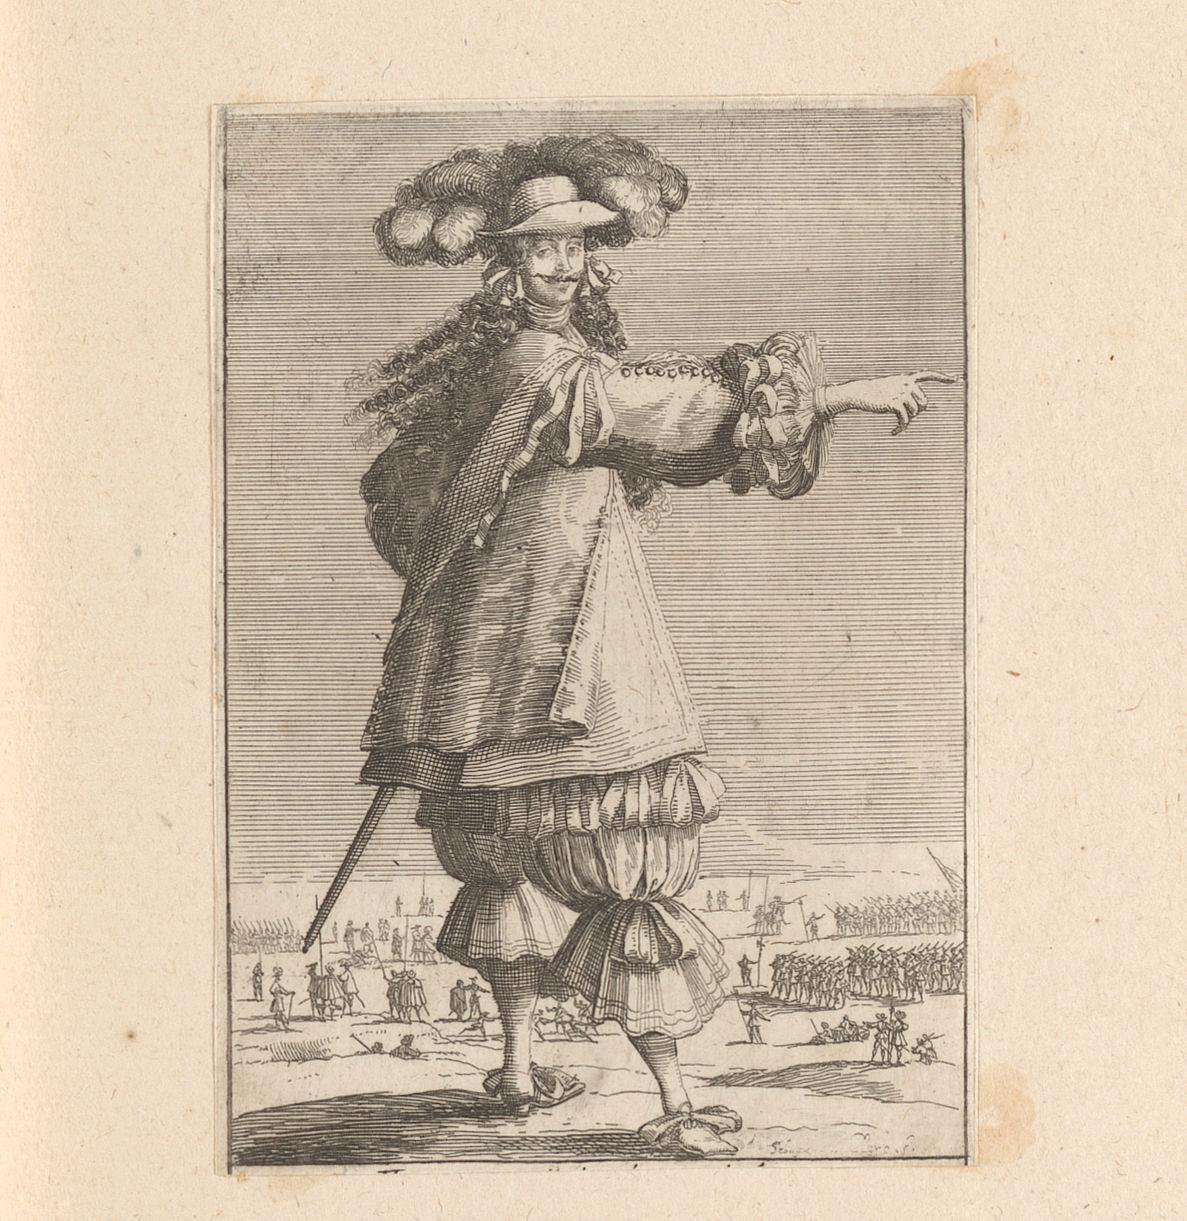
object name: print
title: Les Modes de Metz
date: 1647-1701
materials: paper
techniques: engraving, etching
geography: metz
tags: commander-in-chief, general, marshal, folk costume, regional costume, assembling of military forces; mobilization, troop concentration, etc.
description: Prent maakt deel uit van een 28-delige serie met verschillende figuren uit Metz in de regionale mode. Leclerc vervaardigde de platen te Metz. Landry gaf slechts twintig van de prenten in een serie uit.